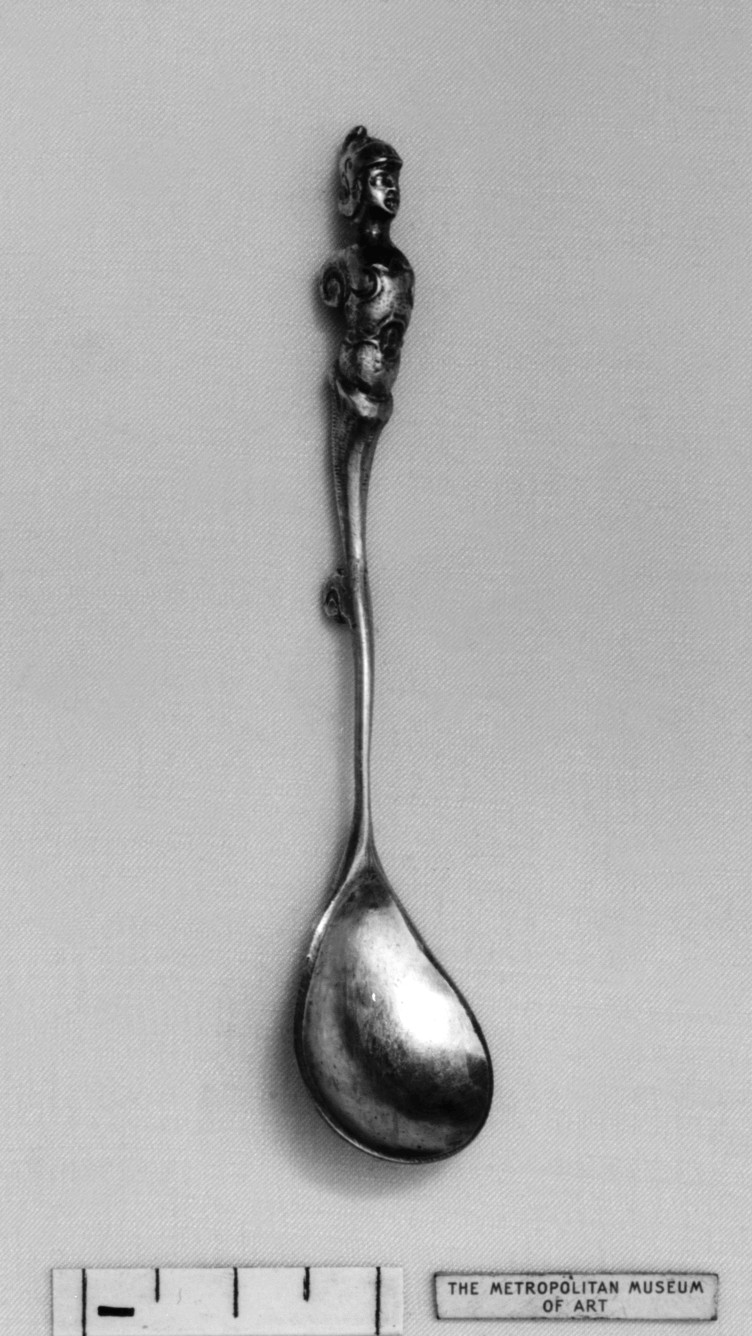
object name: salt spoon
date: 1801-1833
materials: gilt, silver